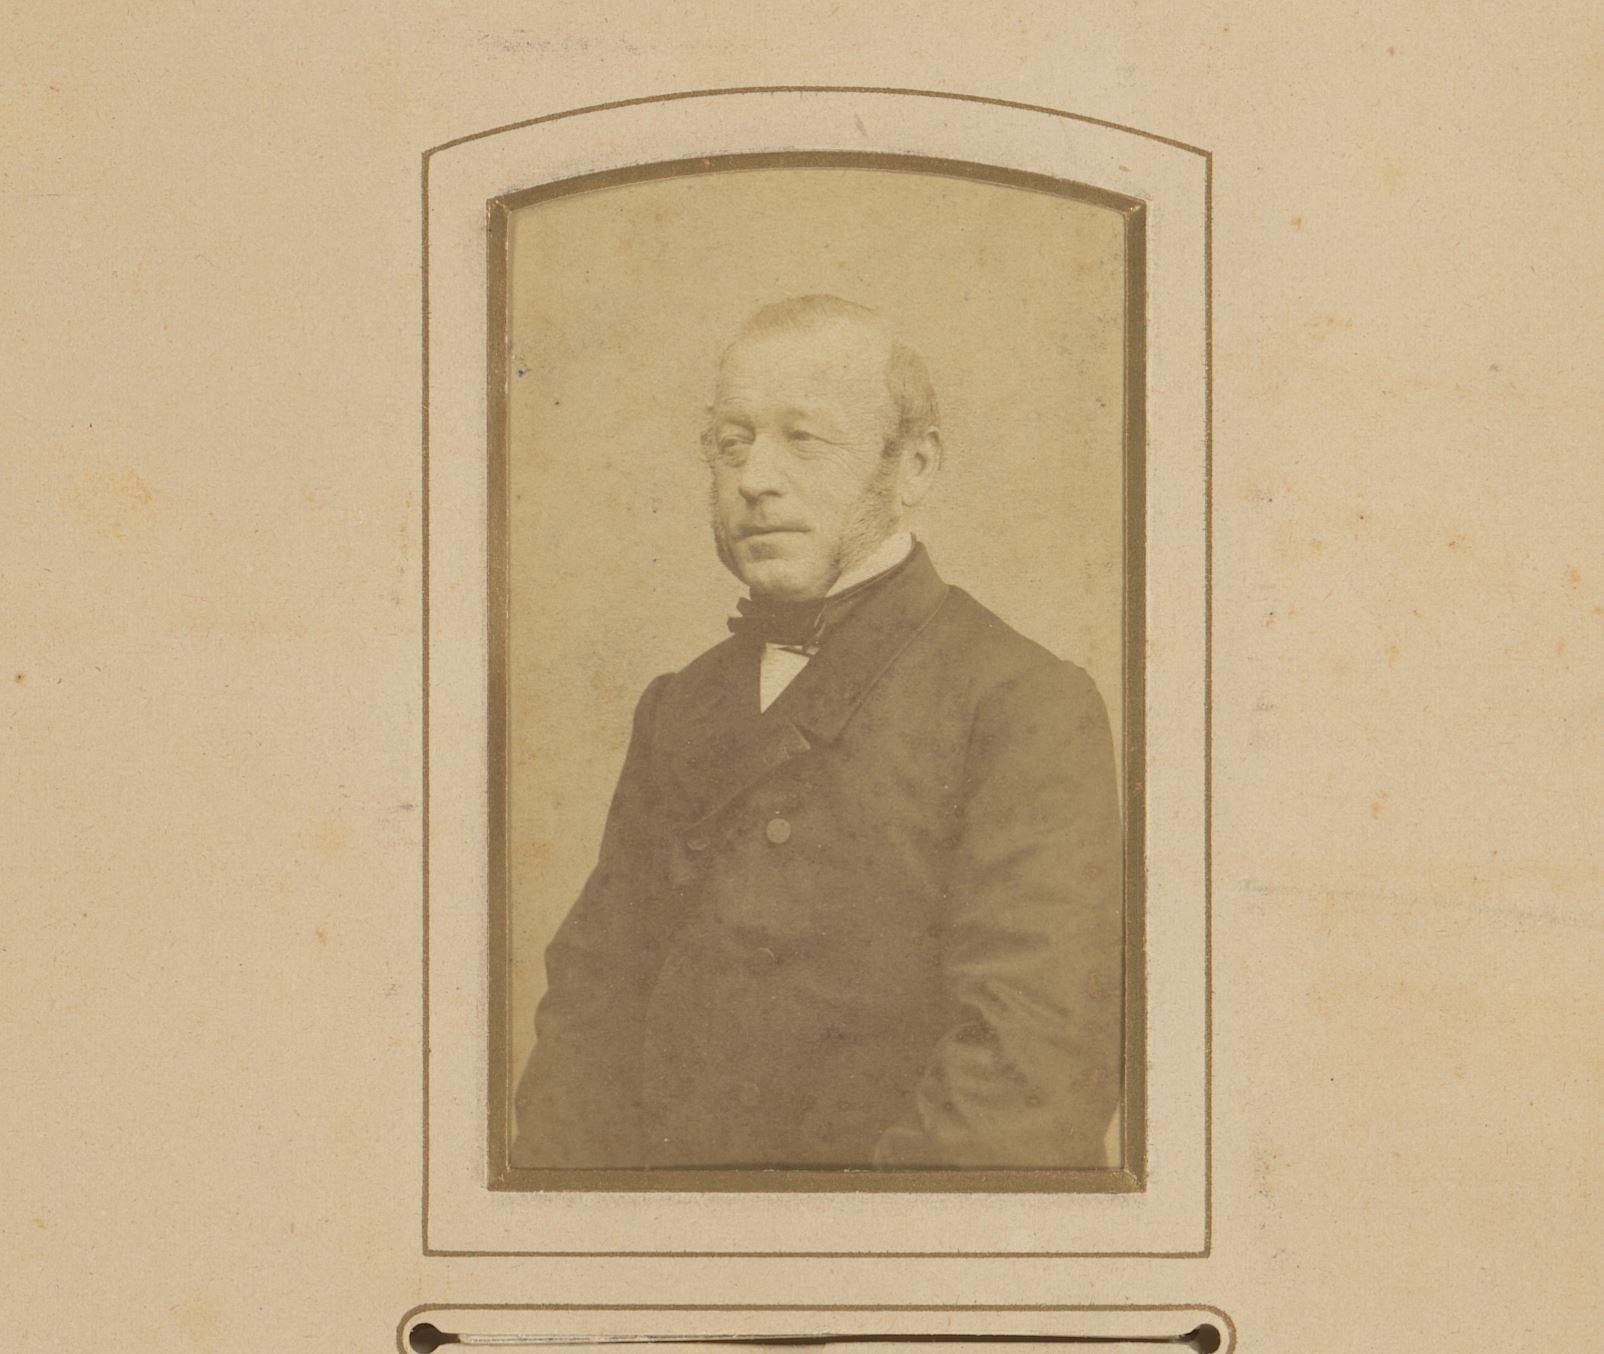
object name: photograph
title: Portret van een man met bakkebaarden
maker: henri blanckart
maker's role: fotograaf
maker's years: 1833-1894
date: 1863-1894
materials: cardboard, photographic support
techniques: albumen print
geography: hasselt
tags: sideburns, historical persons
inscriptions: inscription: ‘H. BLANCKART/ PHOTOGRAPHE/ Près de la Station./ HASSELT.’